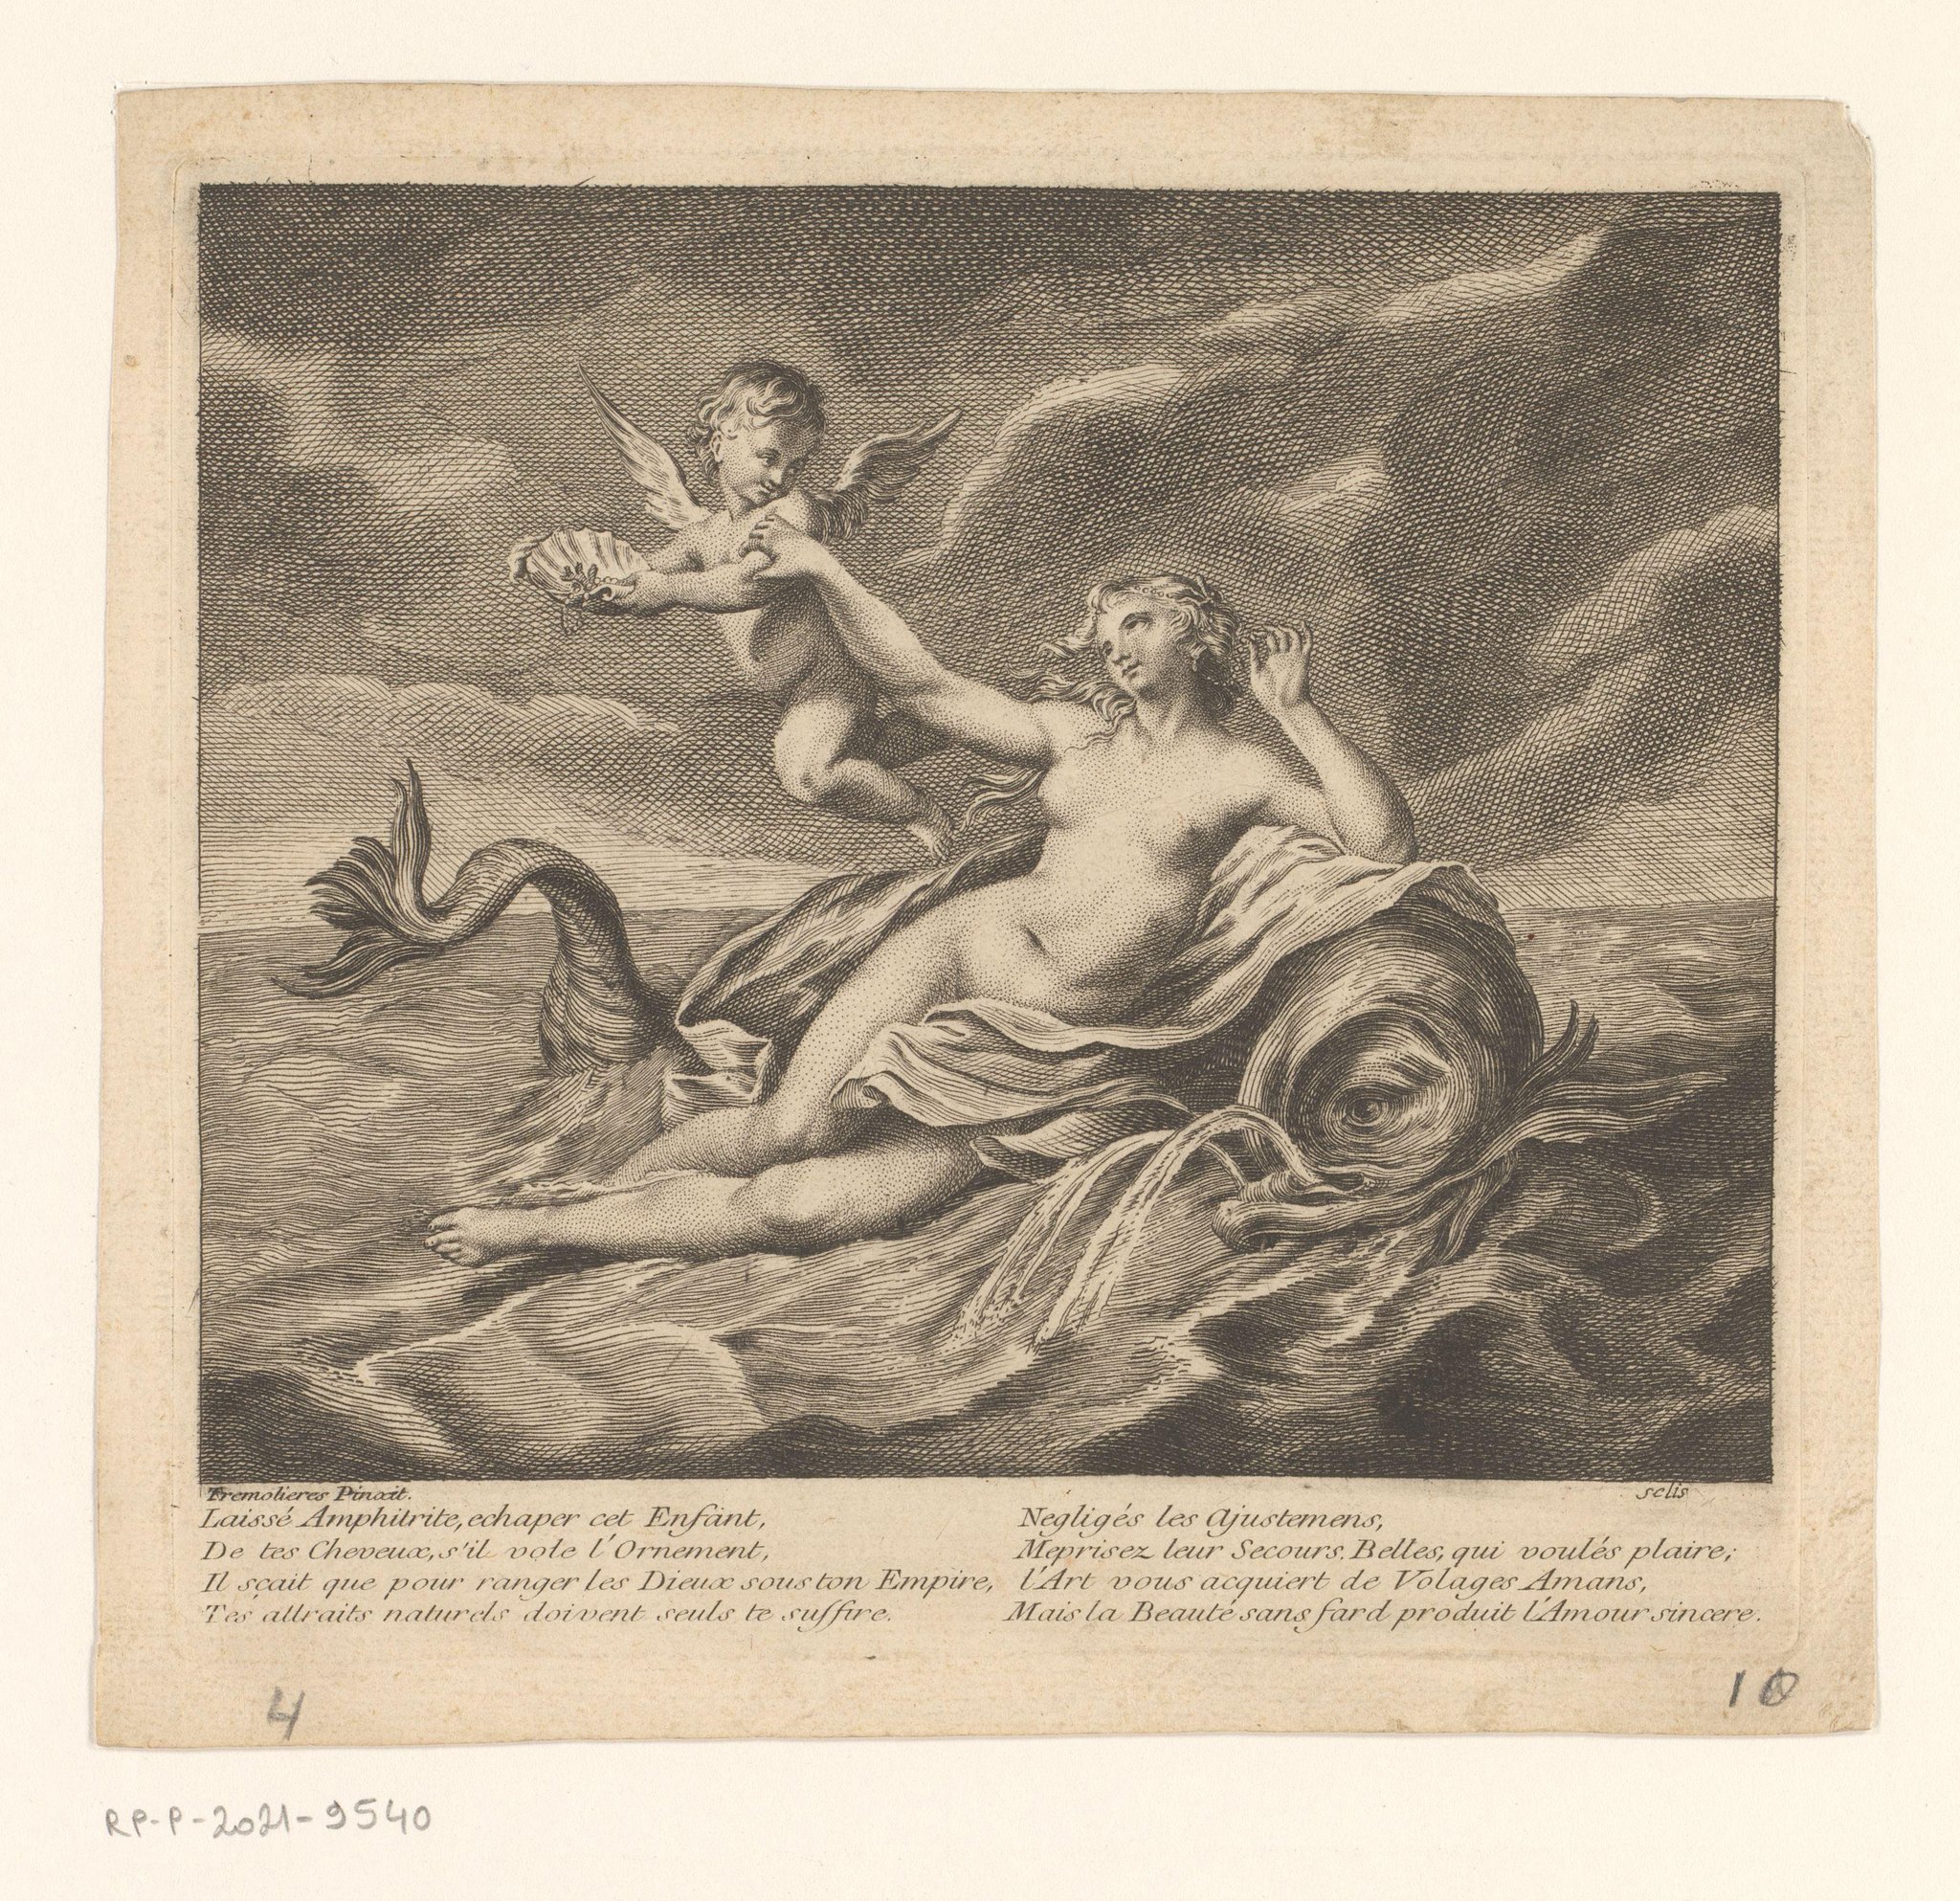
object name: print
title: Amphitrite op een vis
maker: pierre charles trémolière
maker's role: painter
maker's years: 1703-1739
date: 1720-1770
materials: paper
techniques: engraving, etching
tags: amphitrite riding on a dolphin; possibly brought to neptune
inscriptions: signature: ‘selis’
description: Cupido vliegt boven haar met oesterschelp en parels. Met achtregelig vers in twee kolommen in het Frans.